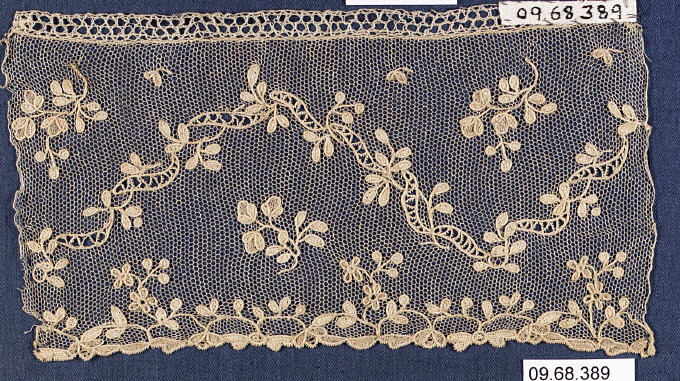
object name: fragment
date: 1801-1900